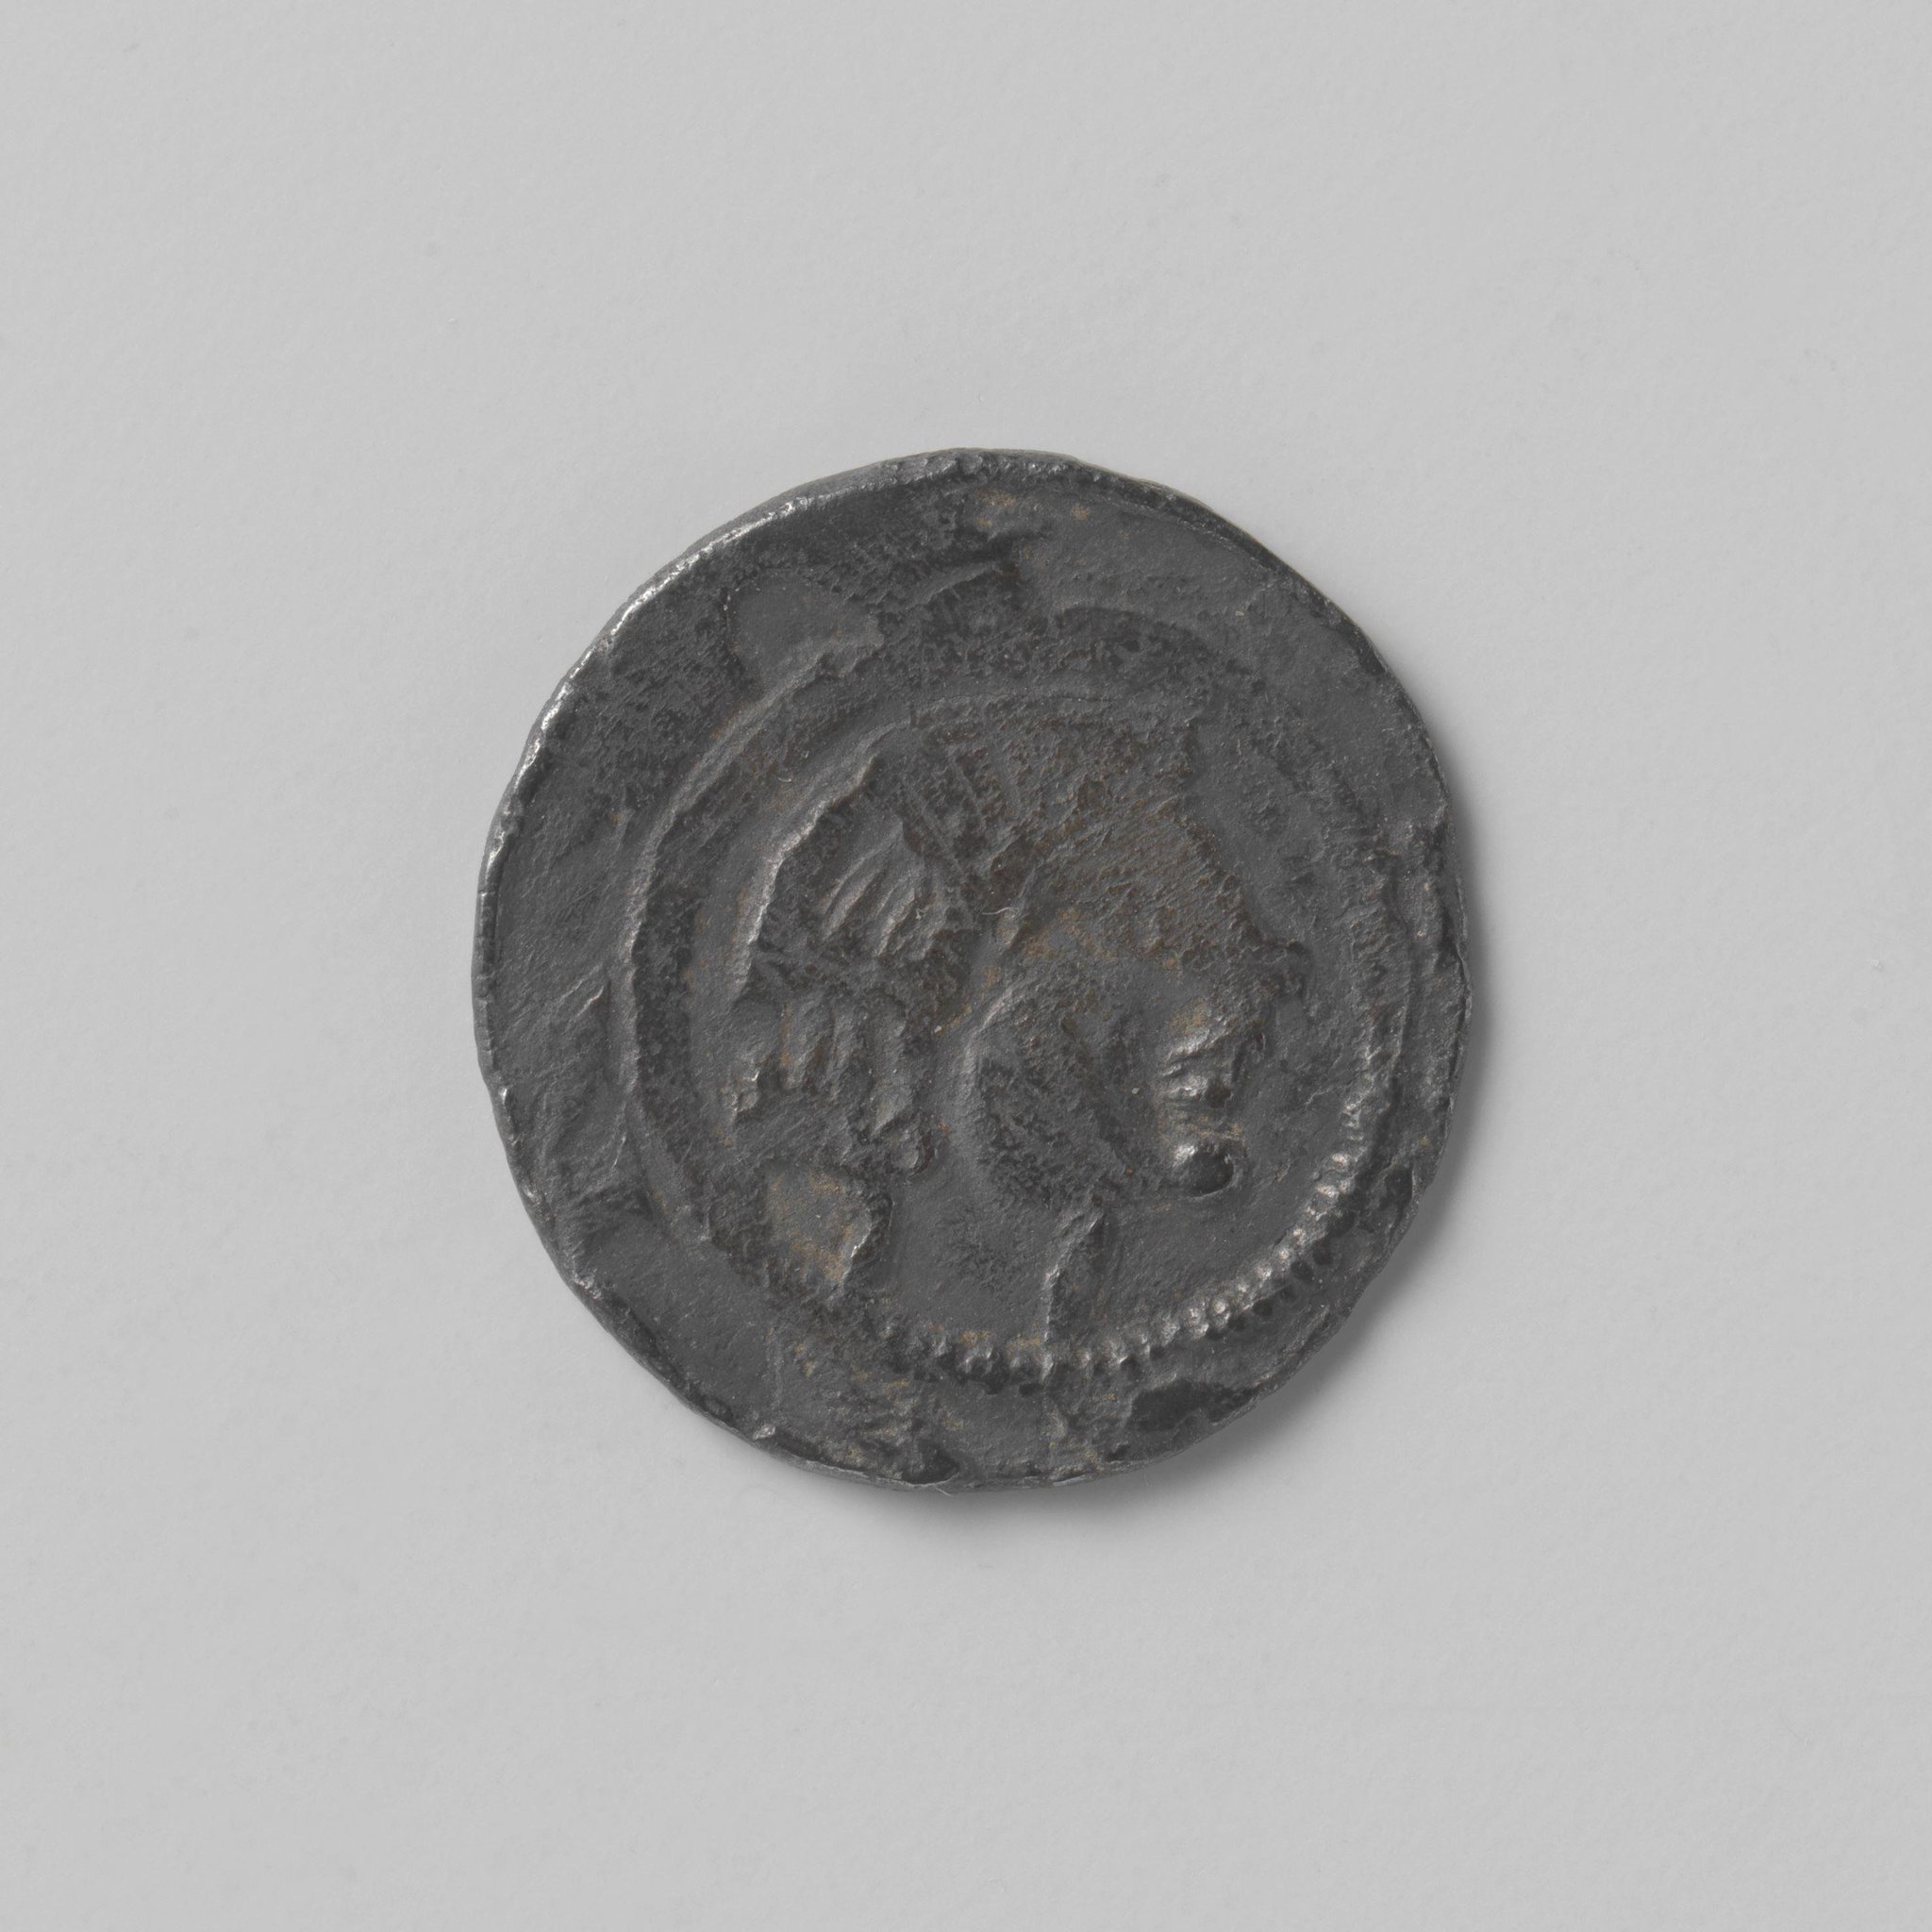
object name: penny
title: Hollandse penning van Floris IV, 1222-1234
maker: floris iv (graaf van holland)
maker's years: 1210-1234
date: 1222-1234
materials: silver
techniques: striking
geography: dordrecht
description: Zilveren munt. Voorzijde: hoofd met gravenmuts naar rechts. Keerzijde: kort dubbellijnig kruis.